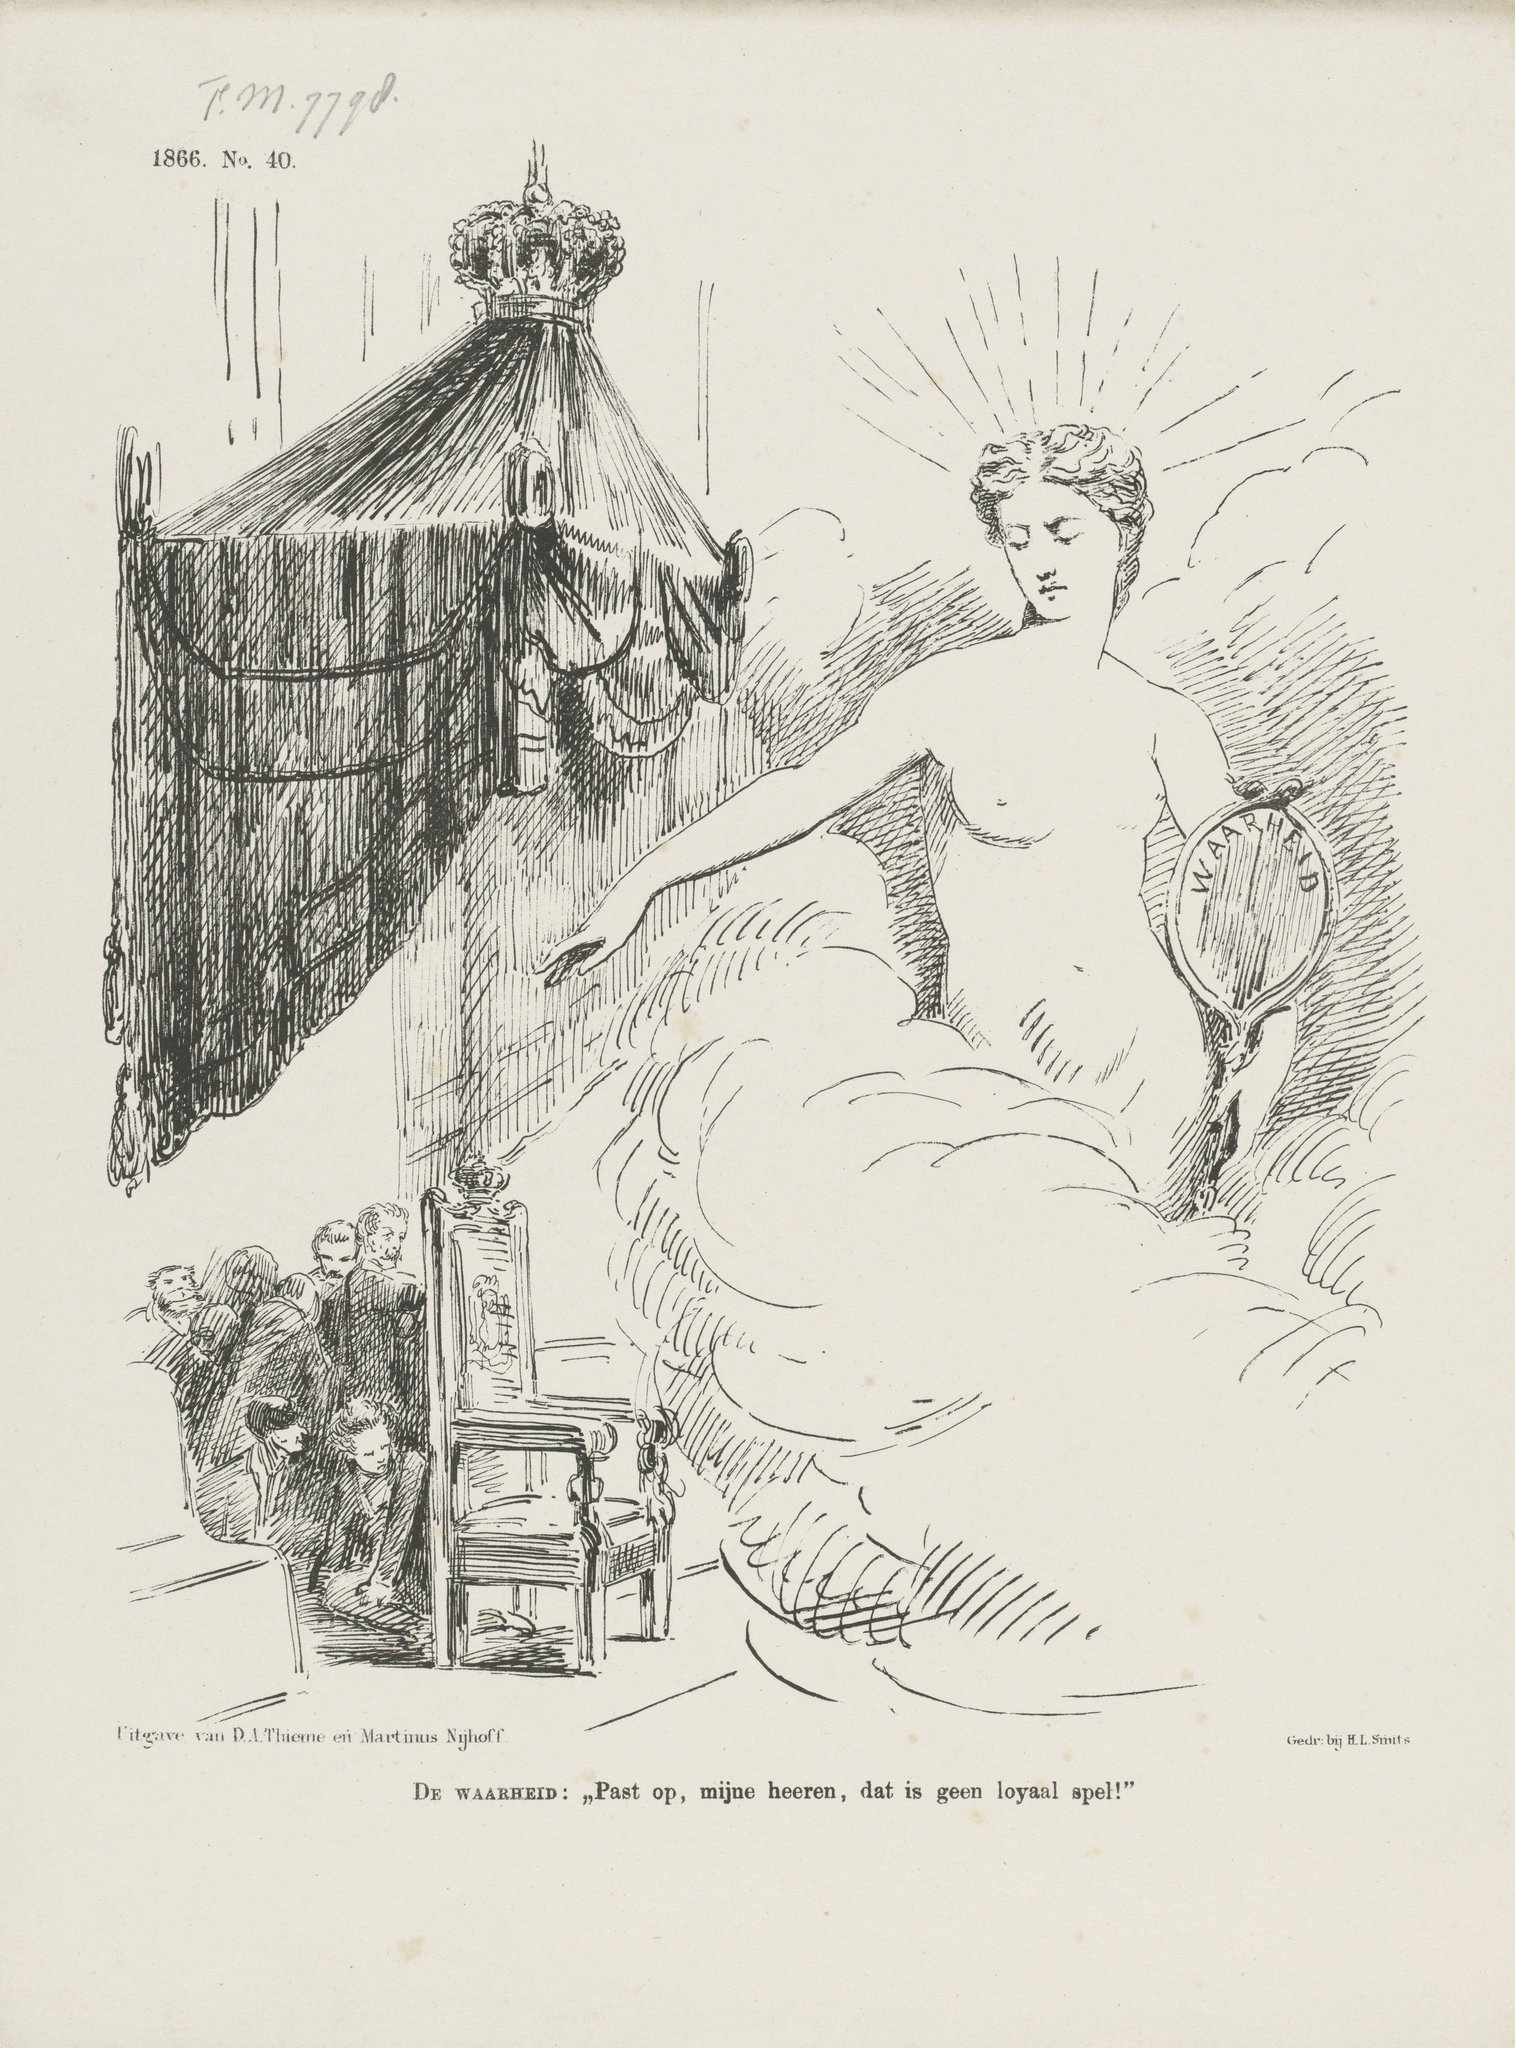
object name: cartoon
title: Spotprent op het beroep van de ministers op het prerogatief van de Kroon tot ontbinding van de Kamers, 1866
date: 1866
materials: paper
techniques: lithograph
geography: netherlands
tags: truth; 'verità' (ripa)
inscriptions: collector's mark: Lugt 2228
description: Spotprent op het beroep van de ministers op het prerogatief van de Kroon tot ontbinding van de Kamers. De ministers verschuilen zich achter de troon bij het verschijnen van de Waarheid in de Tweede kamer. Plaat verschenen bij het weekblad De Nederlandsche Spectator, nr. 40, 6 oktober 1866.